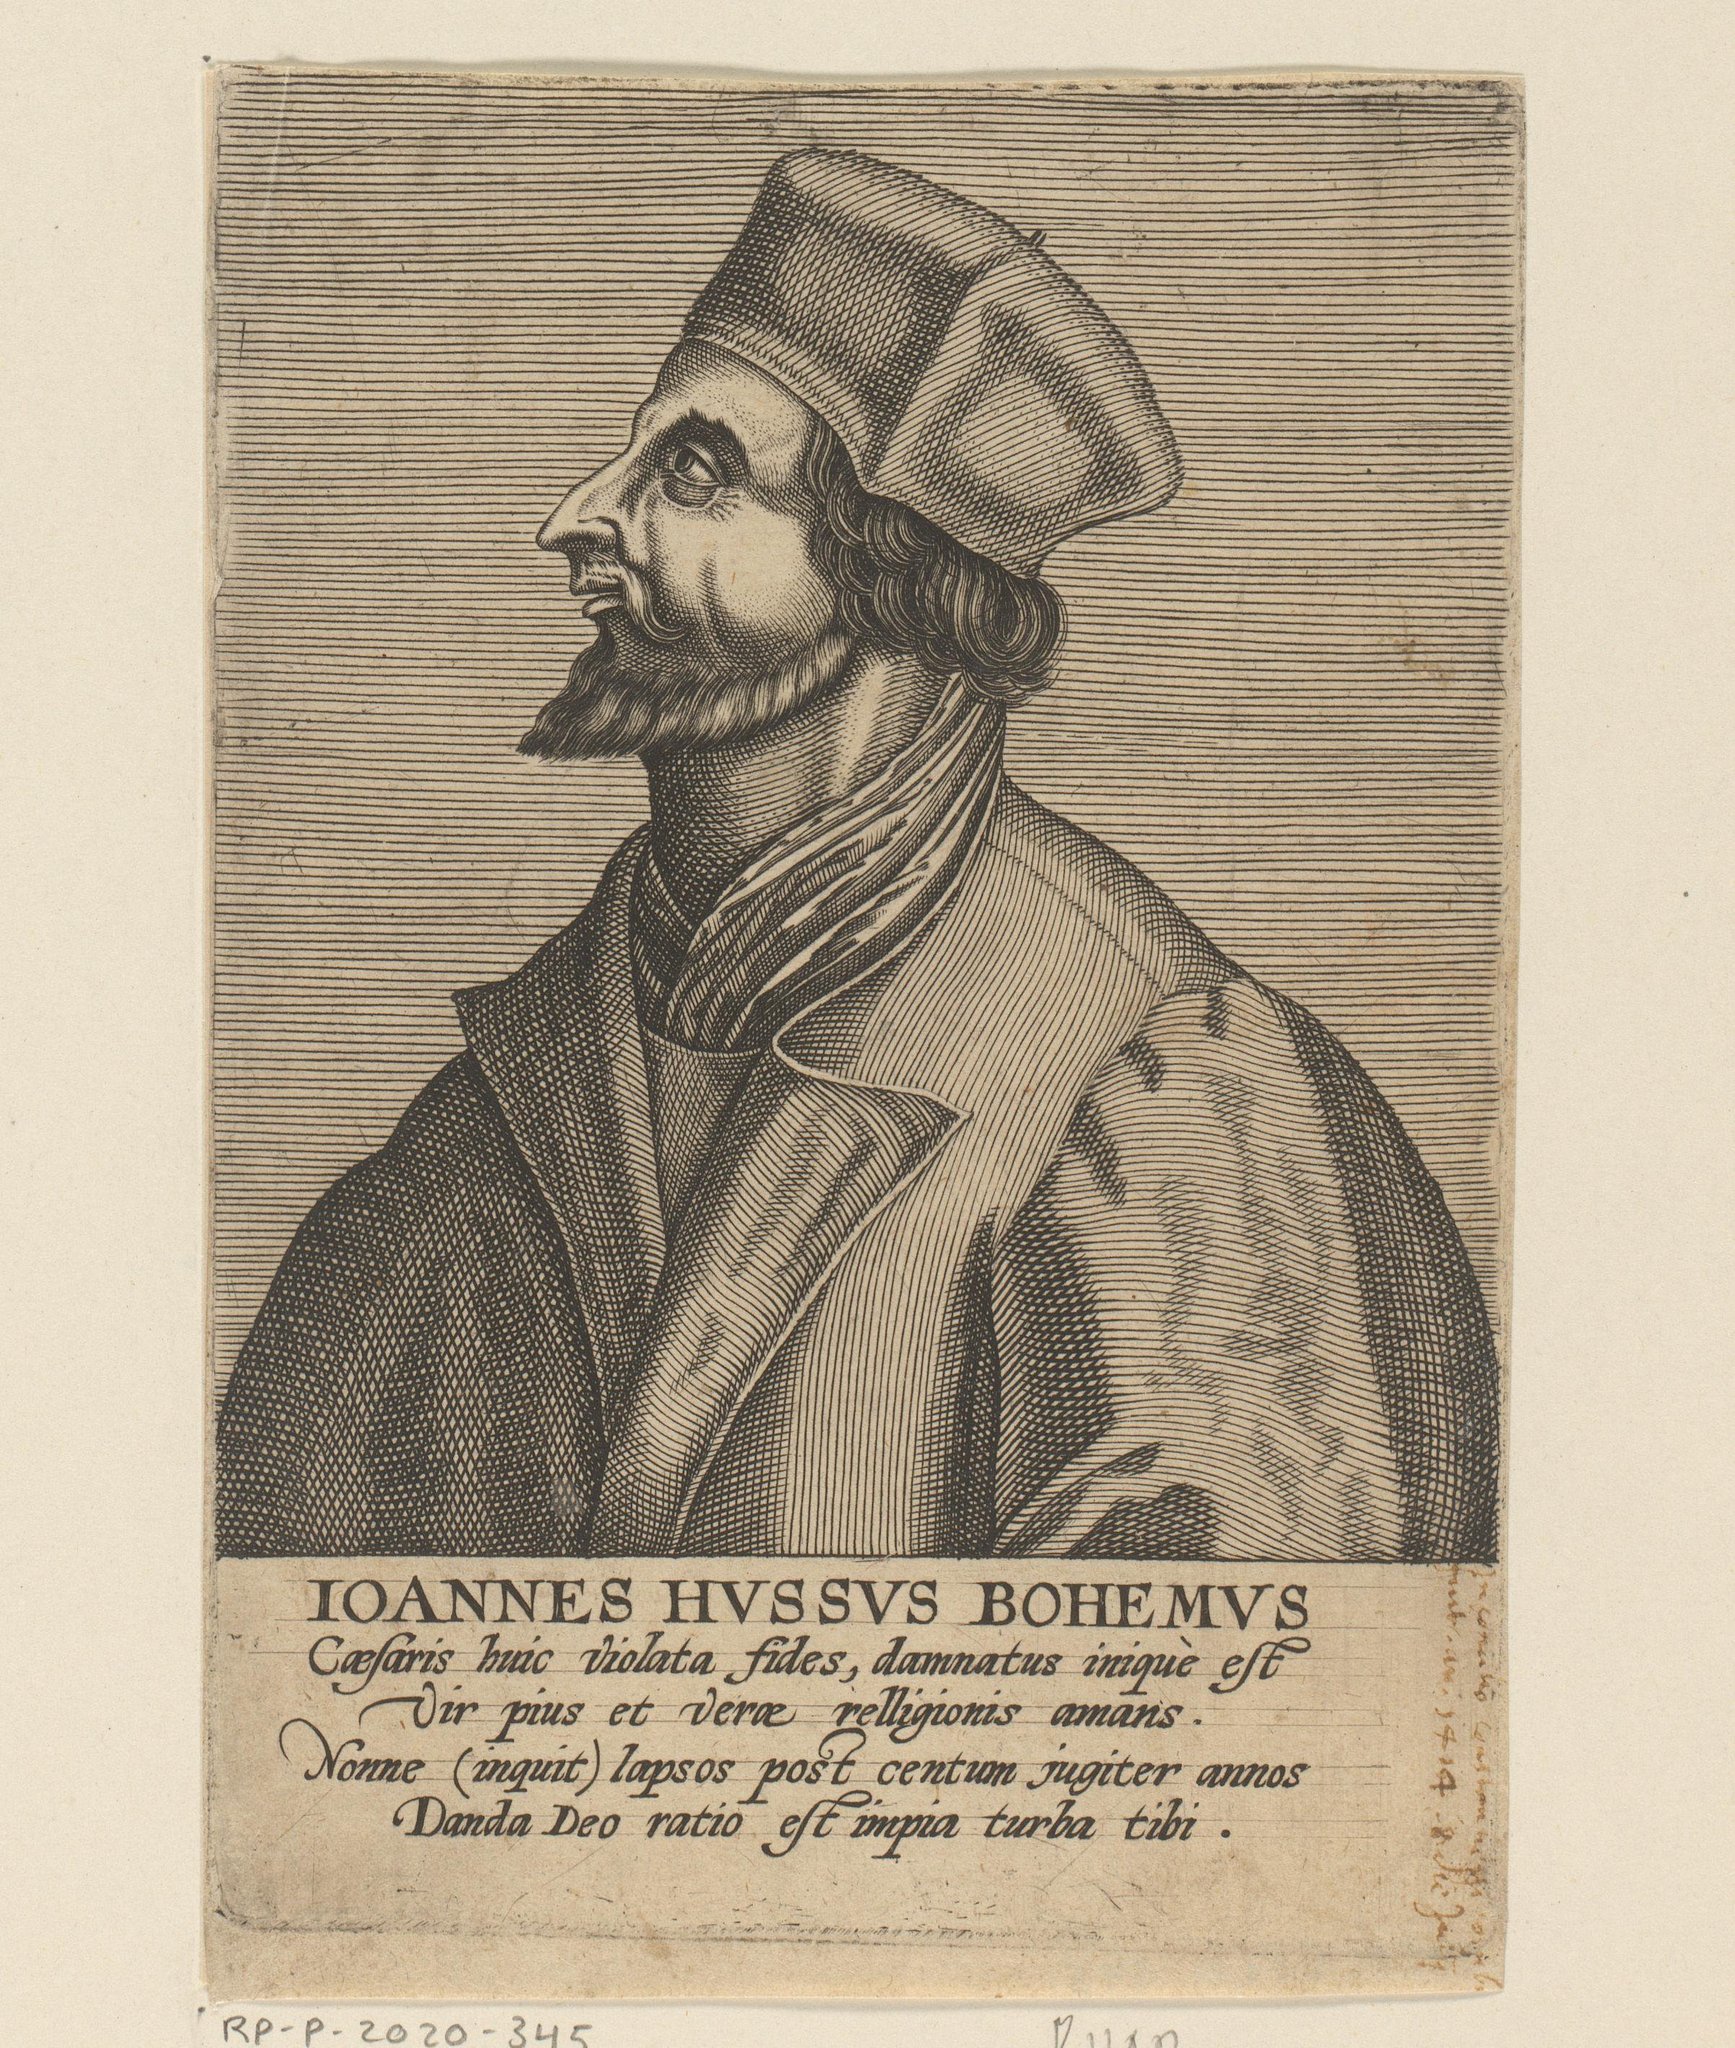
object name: print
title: Portret van Johannes Hus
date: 1600-1649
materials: paper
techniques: engraving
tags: theologian, historical persons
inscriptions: inscription: ‘[...]’